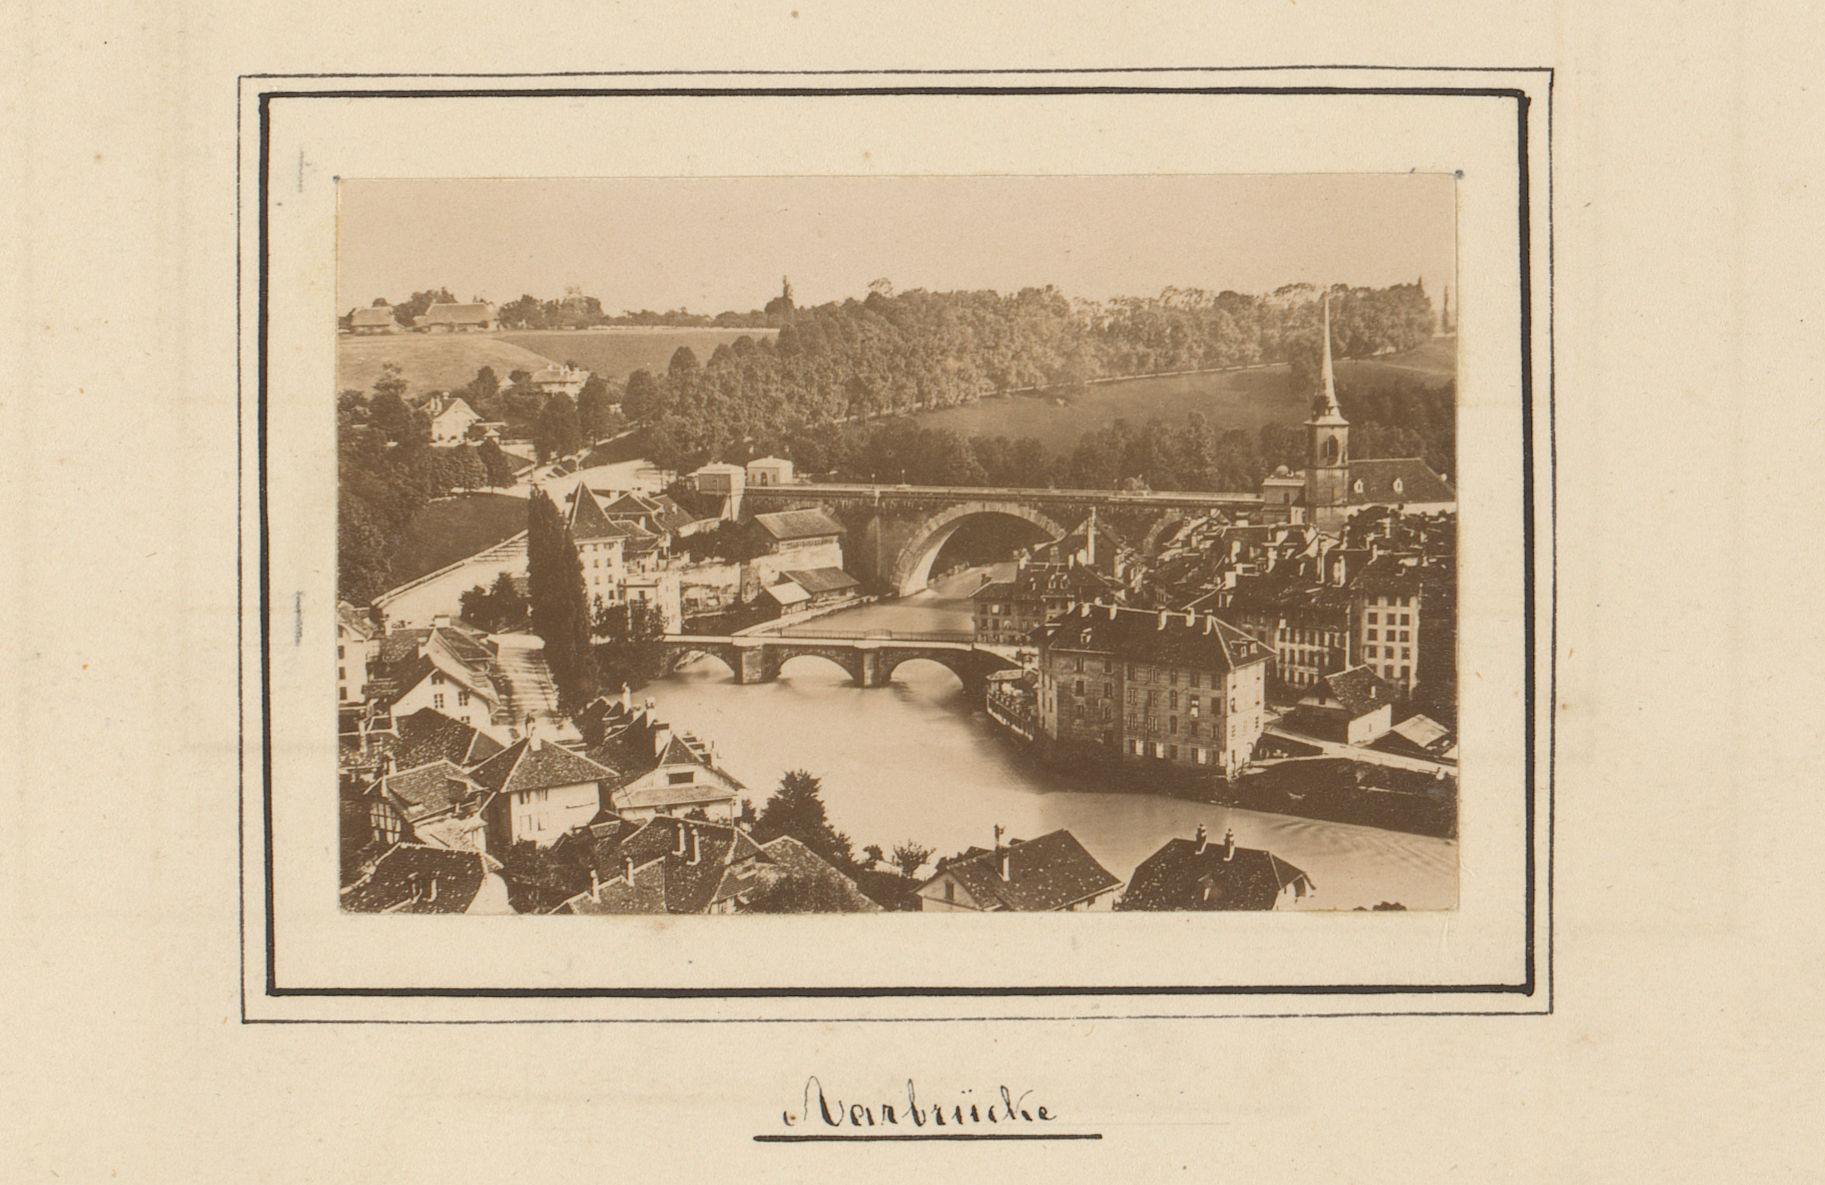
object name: album leaf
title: Gezicht op de Aare in Bern met de Untertorbrücke en de Nydeggbrücke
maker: Anonymous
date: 1870-1900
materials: paper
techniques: albumen print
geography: bern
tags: bridge in city across river, canal, etc.